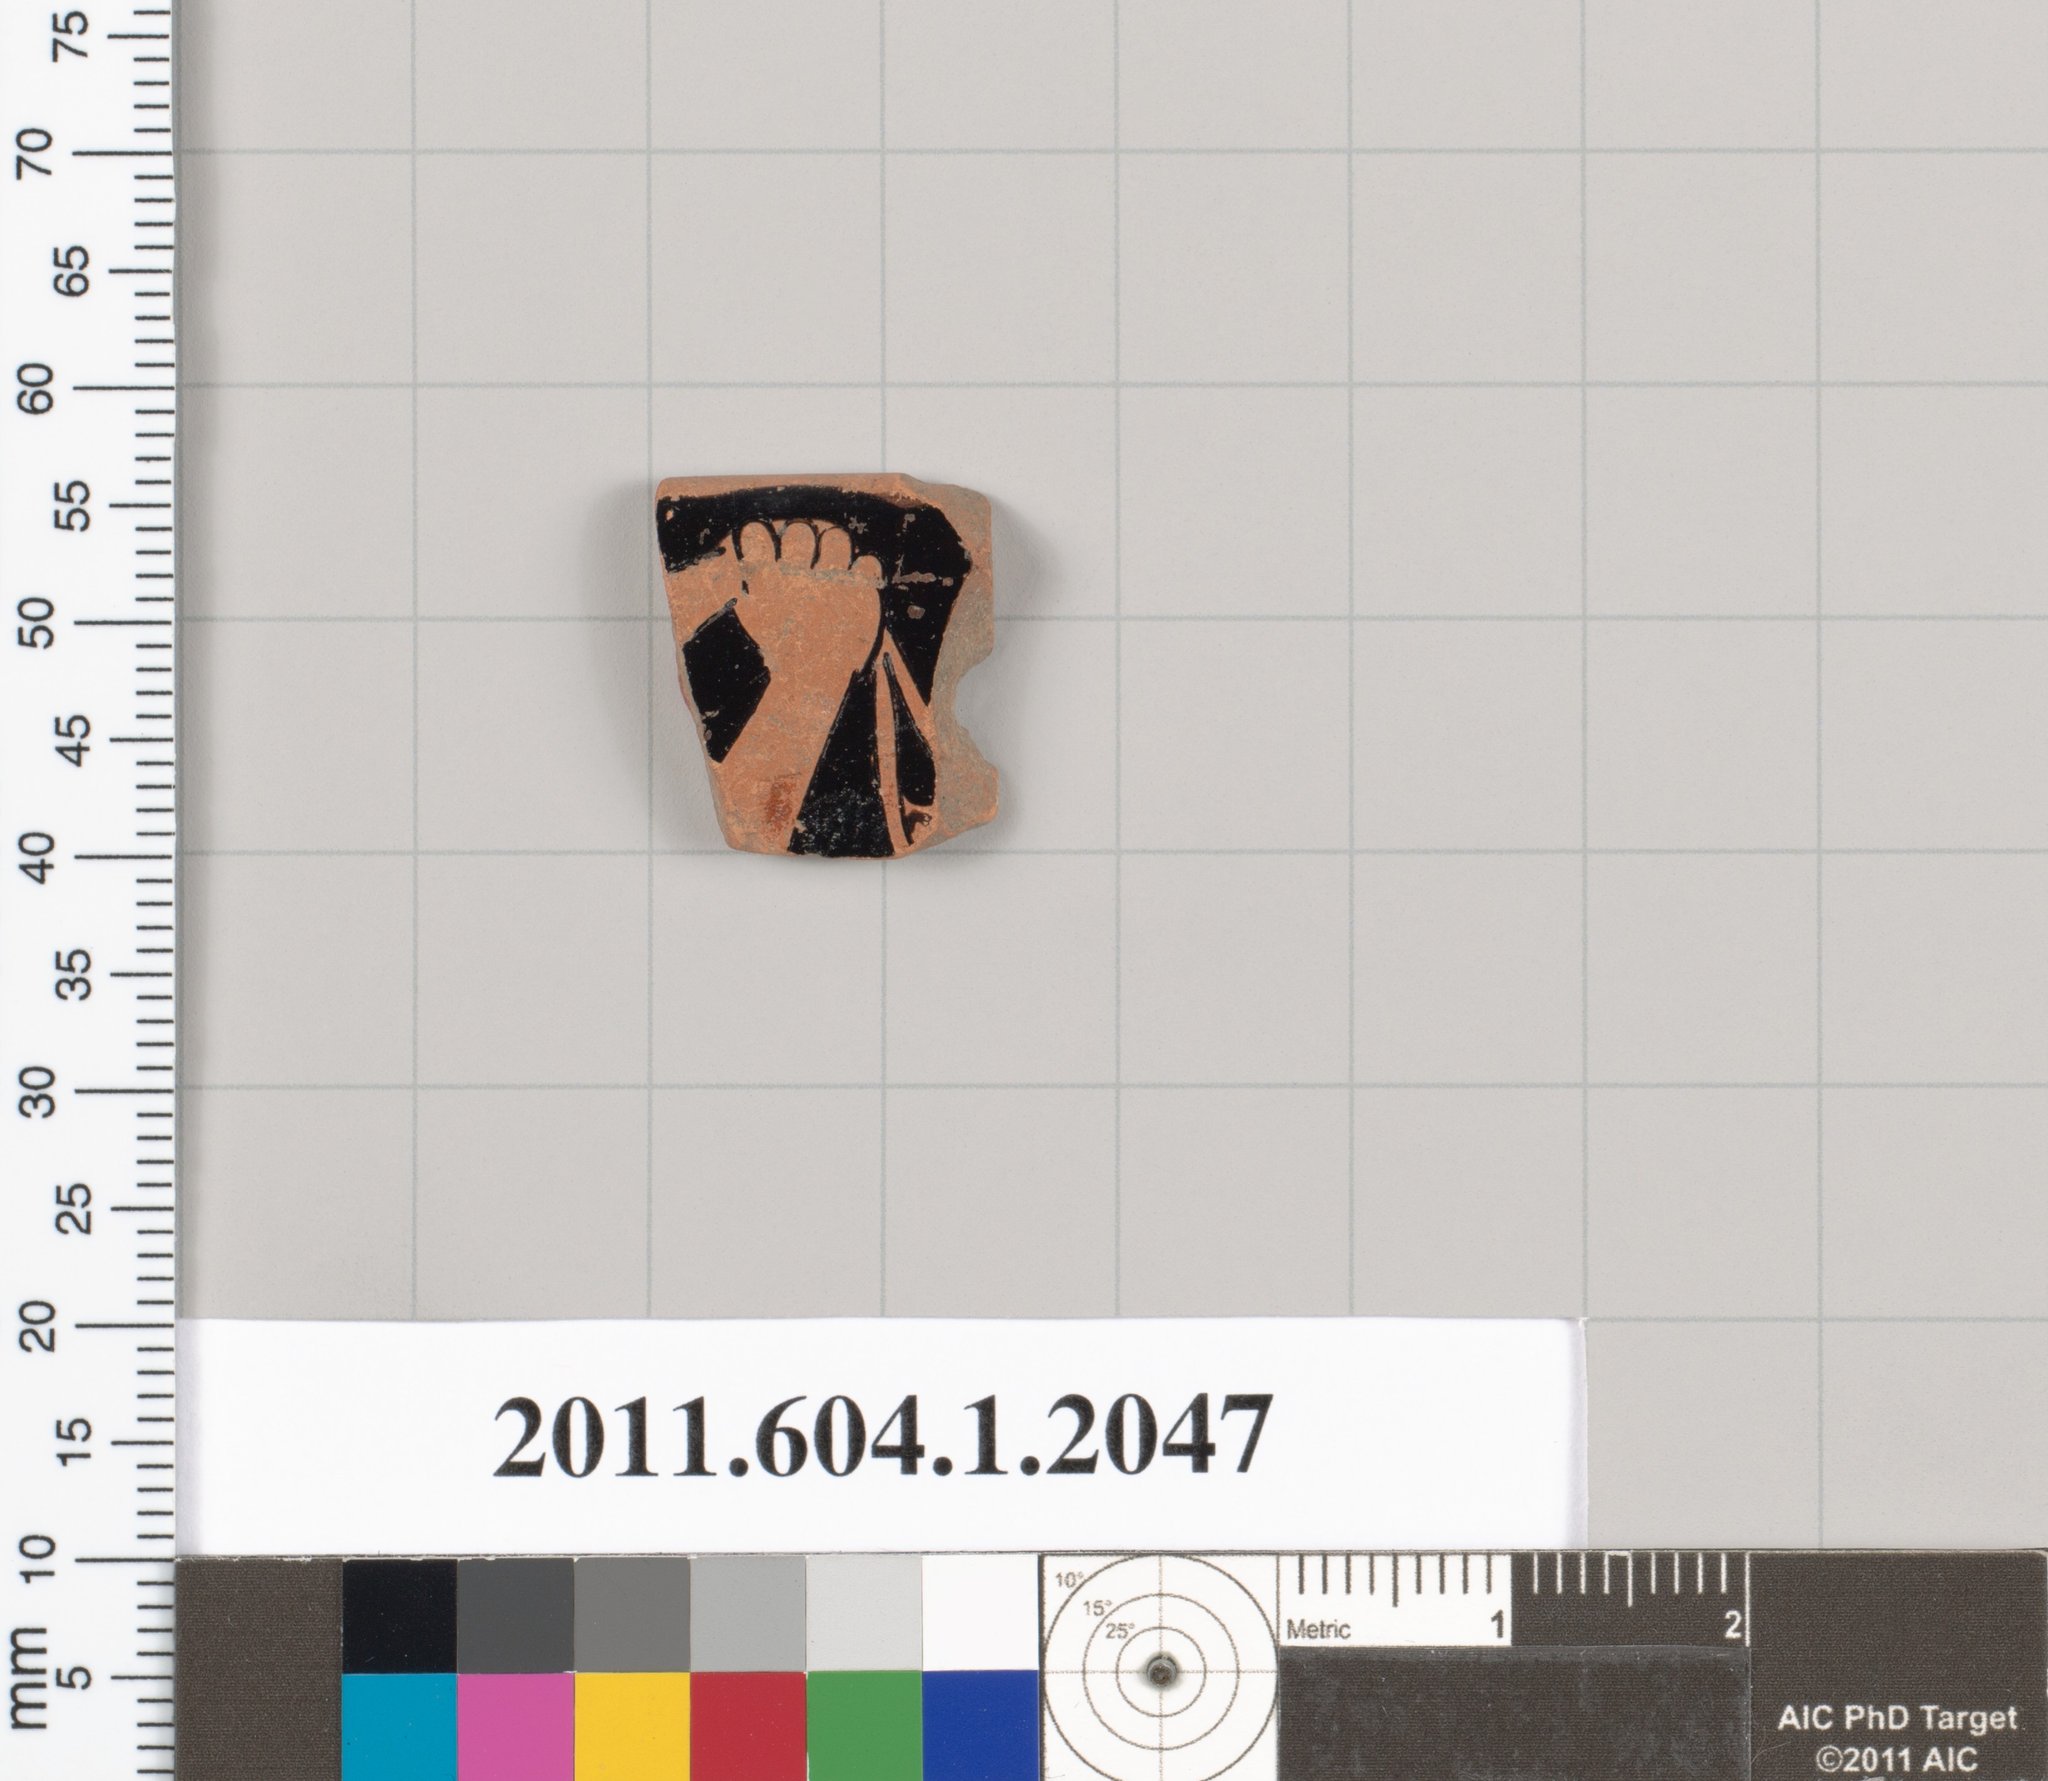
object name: kylix fragment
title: Terracotta rim fragment of a kylix (drinking cup)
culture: greek, attic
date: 500-480 BCE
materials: terracotta